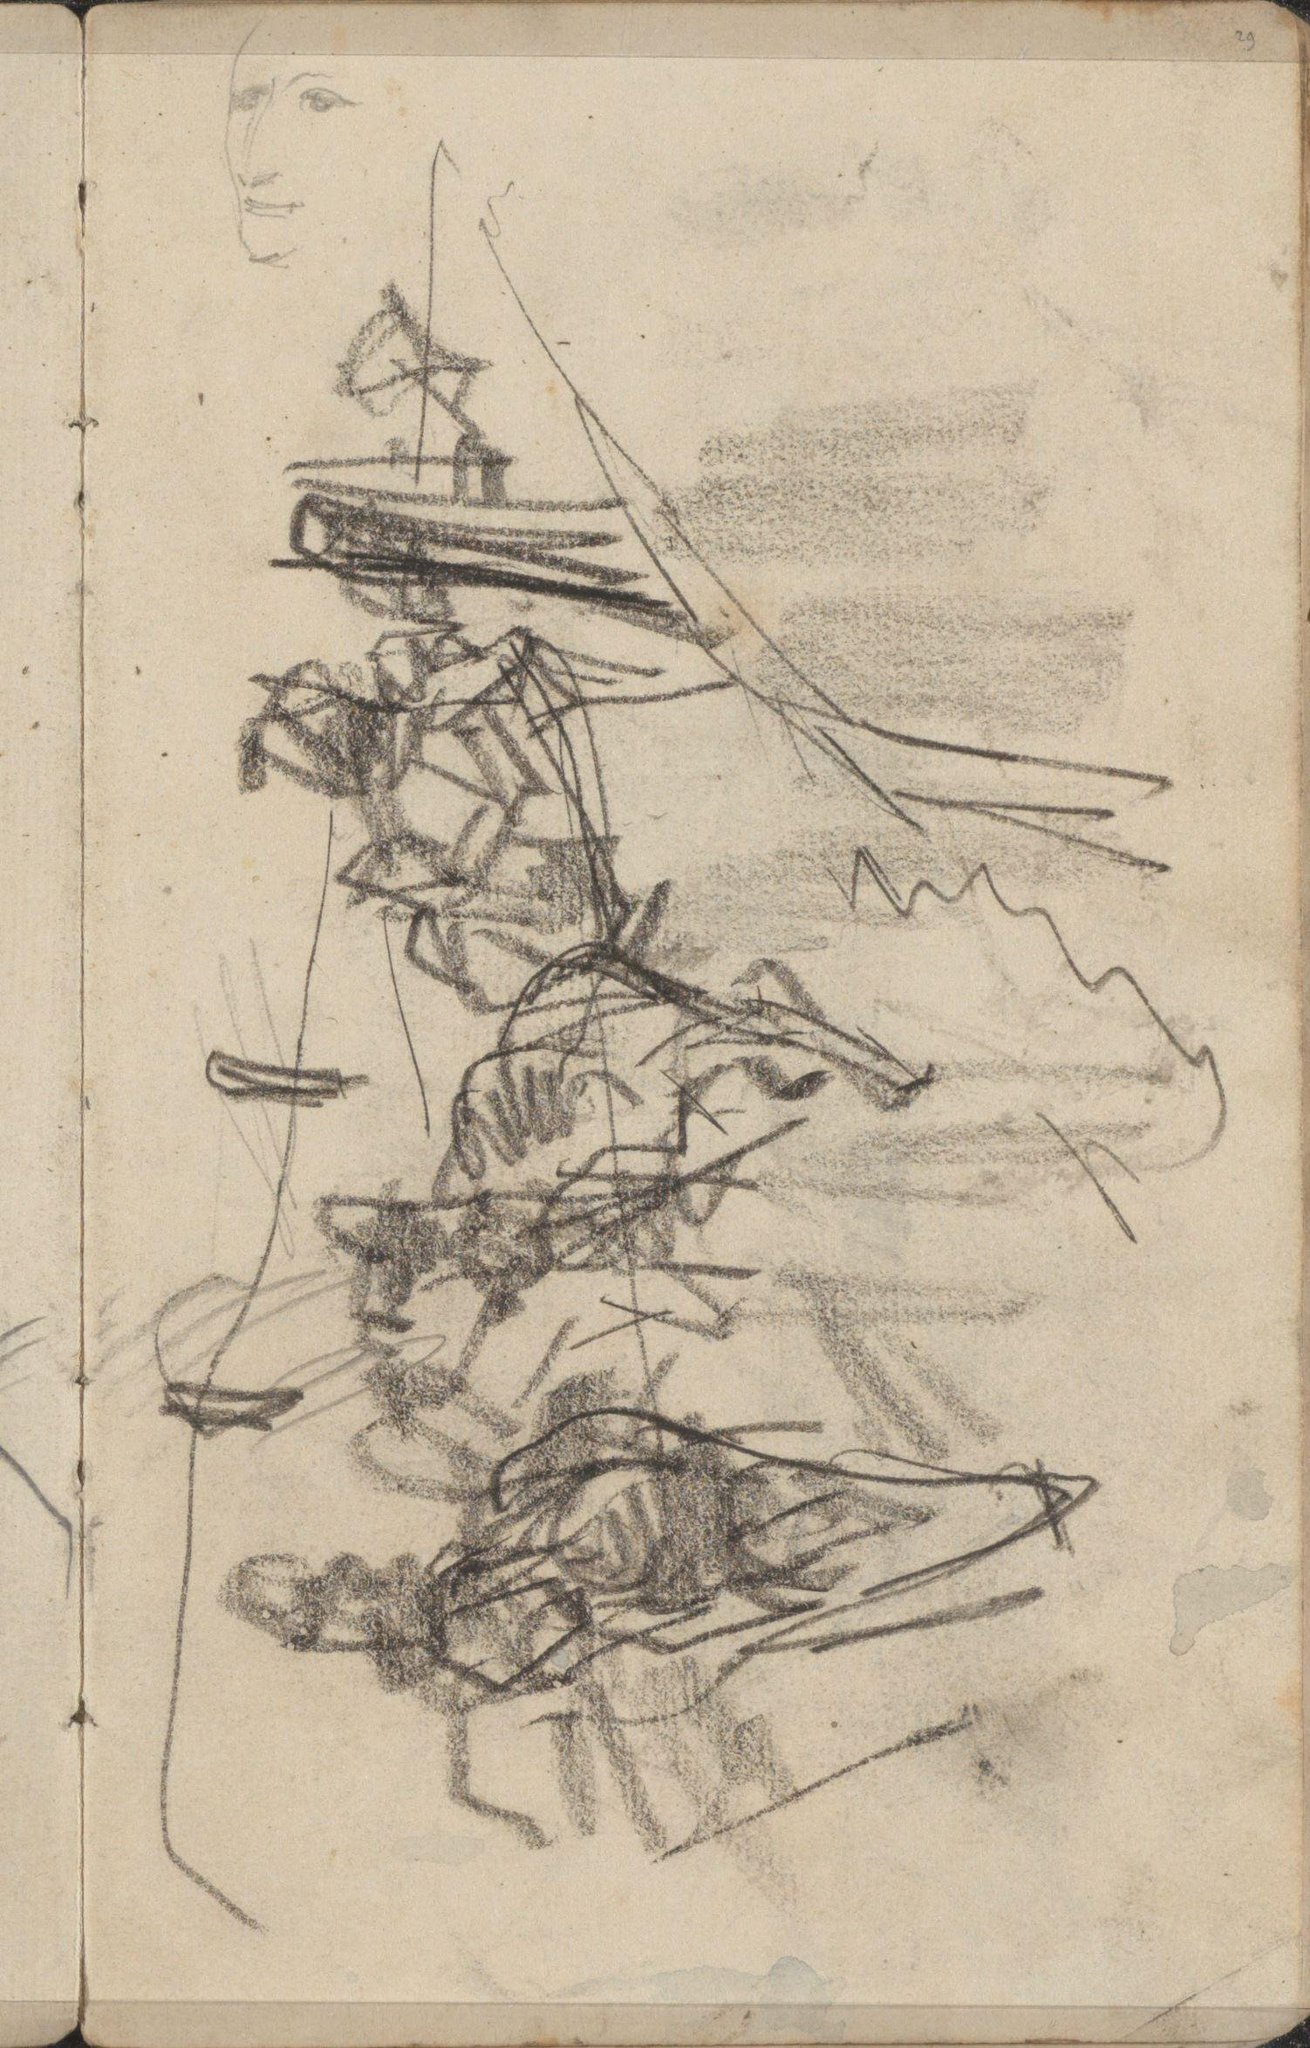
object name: sketchbook leaf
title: Rijdende artilleristen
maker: george hendrik breitner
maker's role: draughtsman, painter, print maker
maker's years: 1857-1923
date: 1881-1883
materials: chalk, paper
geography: the hague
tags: division of armed forces (+ artillery)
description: Studie voor de aquarel 'Artillerie op brug' uit de collectie van Gemeentemuseum, Den Haag.